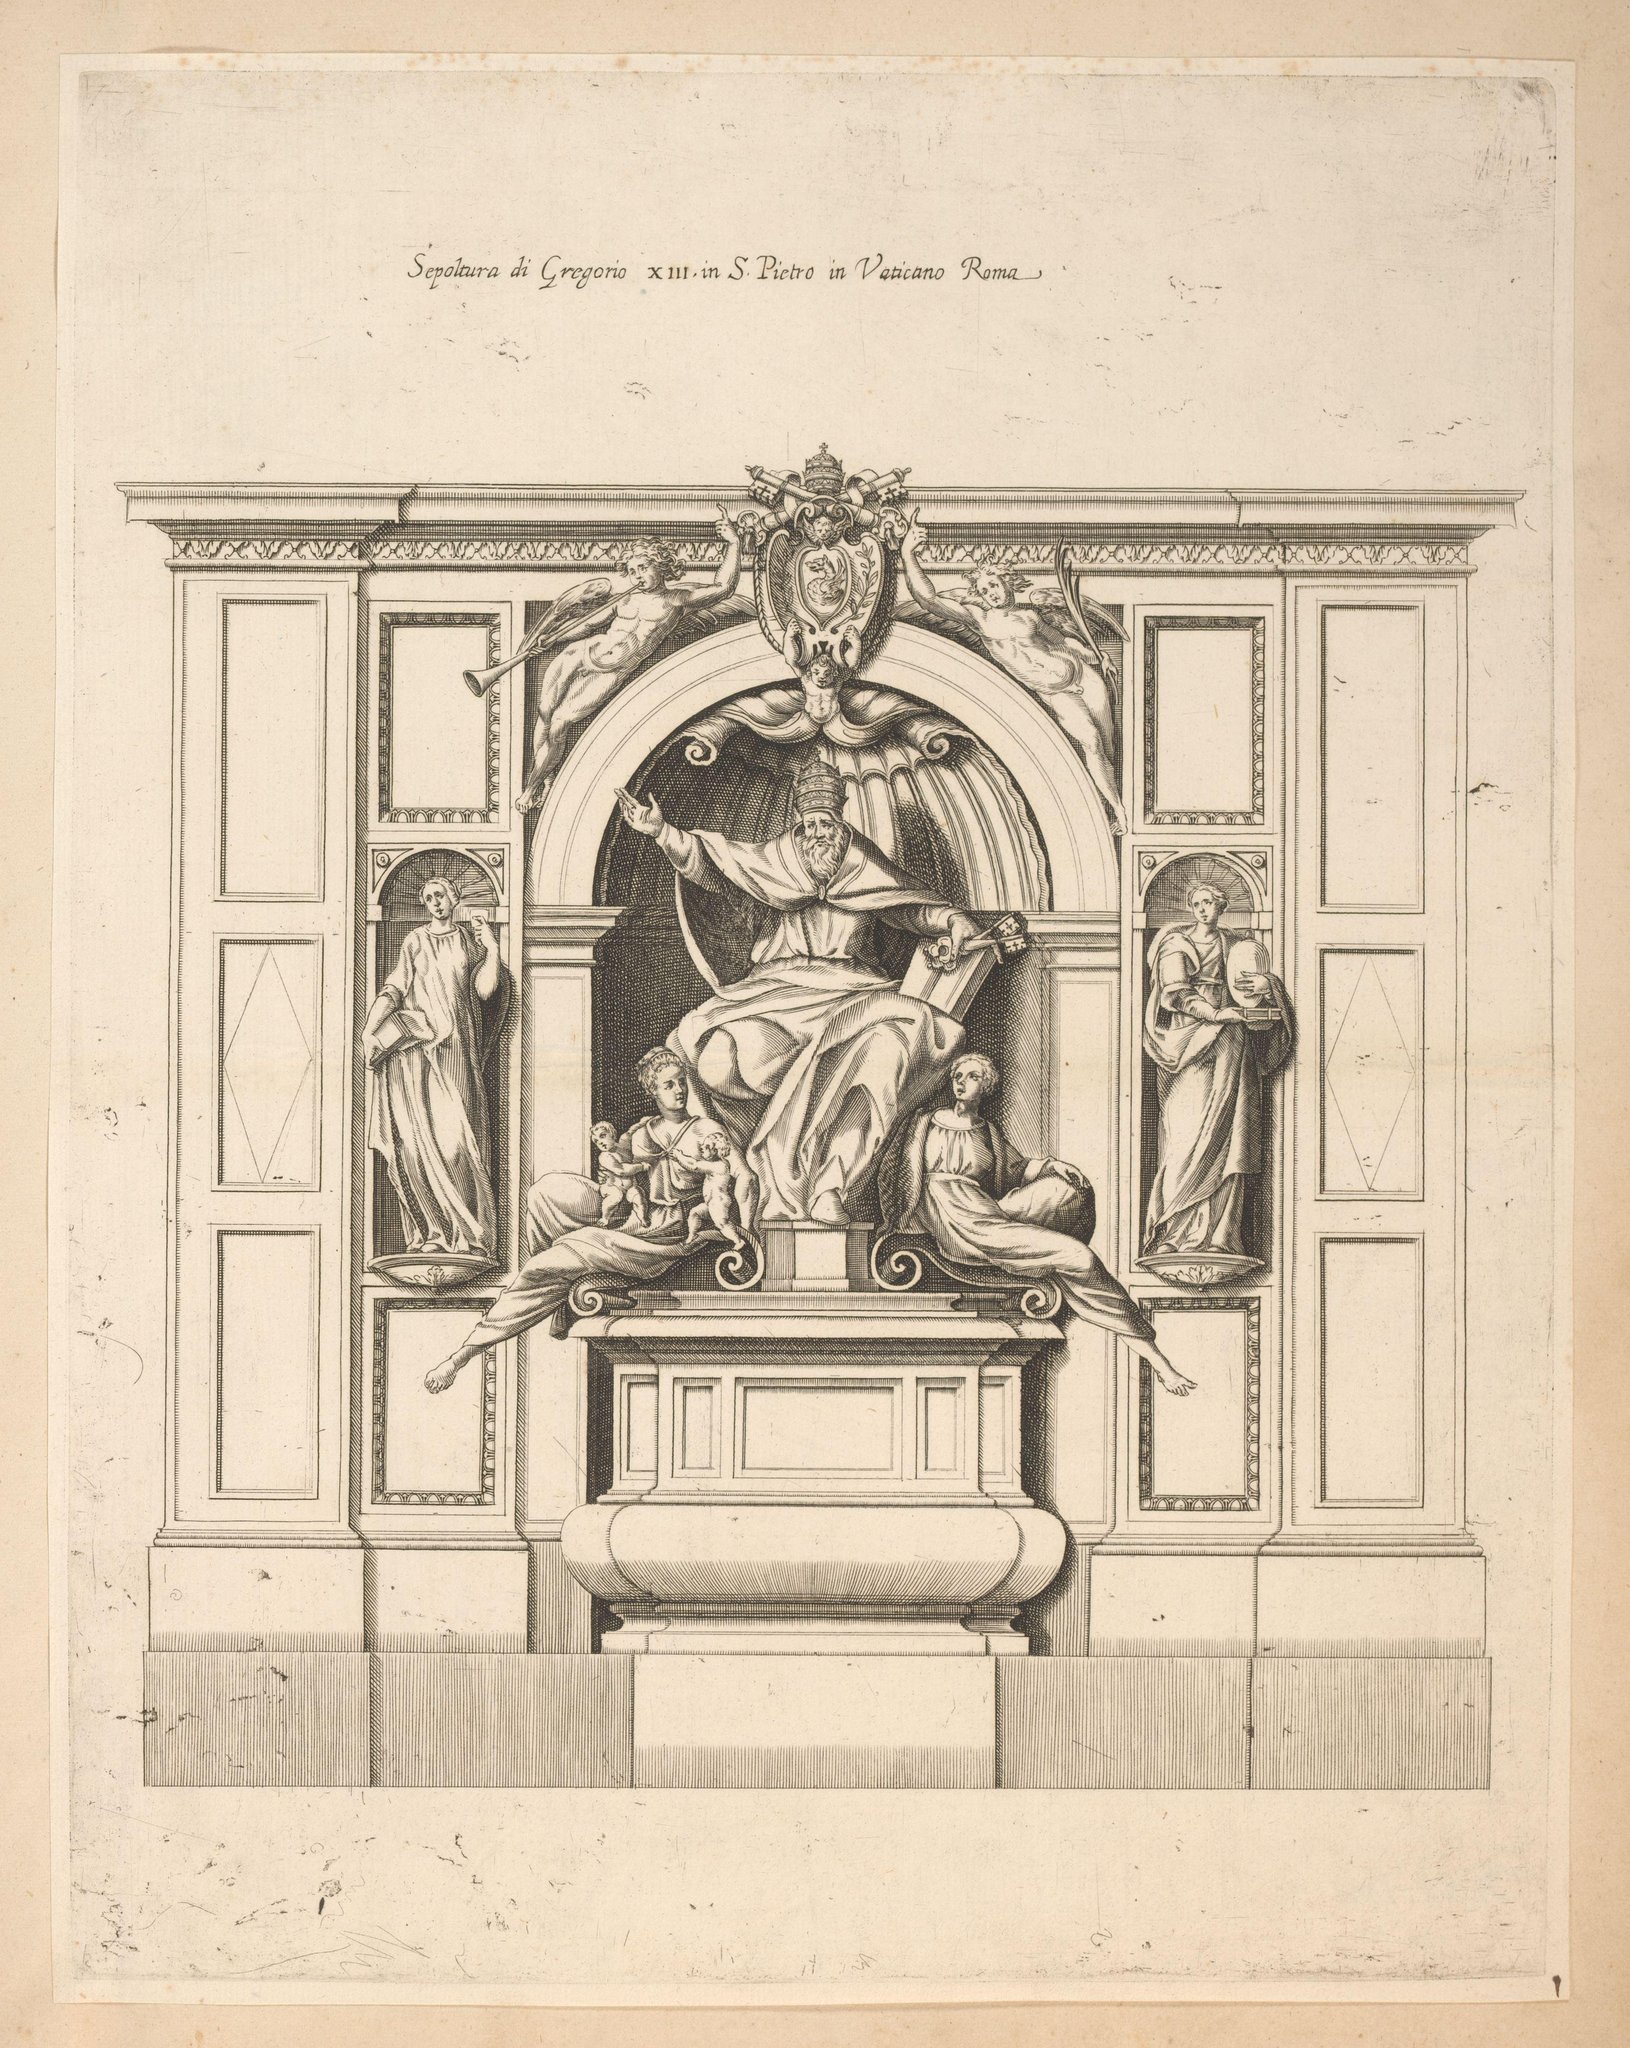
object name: album leaf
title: Sepoltura di Gregorio XIII. in S. Pietro in Vaticano Roma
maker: Anonymous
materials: paper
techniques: engraving, intaglio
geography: italy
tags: rome, gregorius xiii, niche-tomb, wall-tomb, piece of sculpture, reproduction of a piece of sculpture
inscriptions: number: ‘1’, number: ‘75’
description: Het verloren gegane grafmonument van paus Gregorius XIII in de Sint-Pietersbasiliek in het Vaticaan. Prent maakt deel uit van een album.